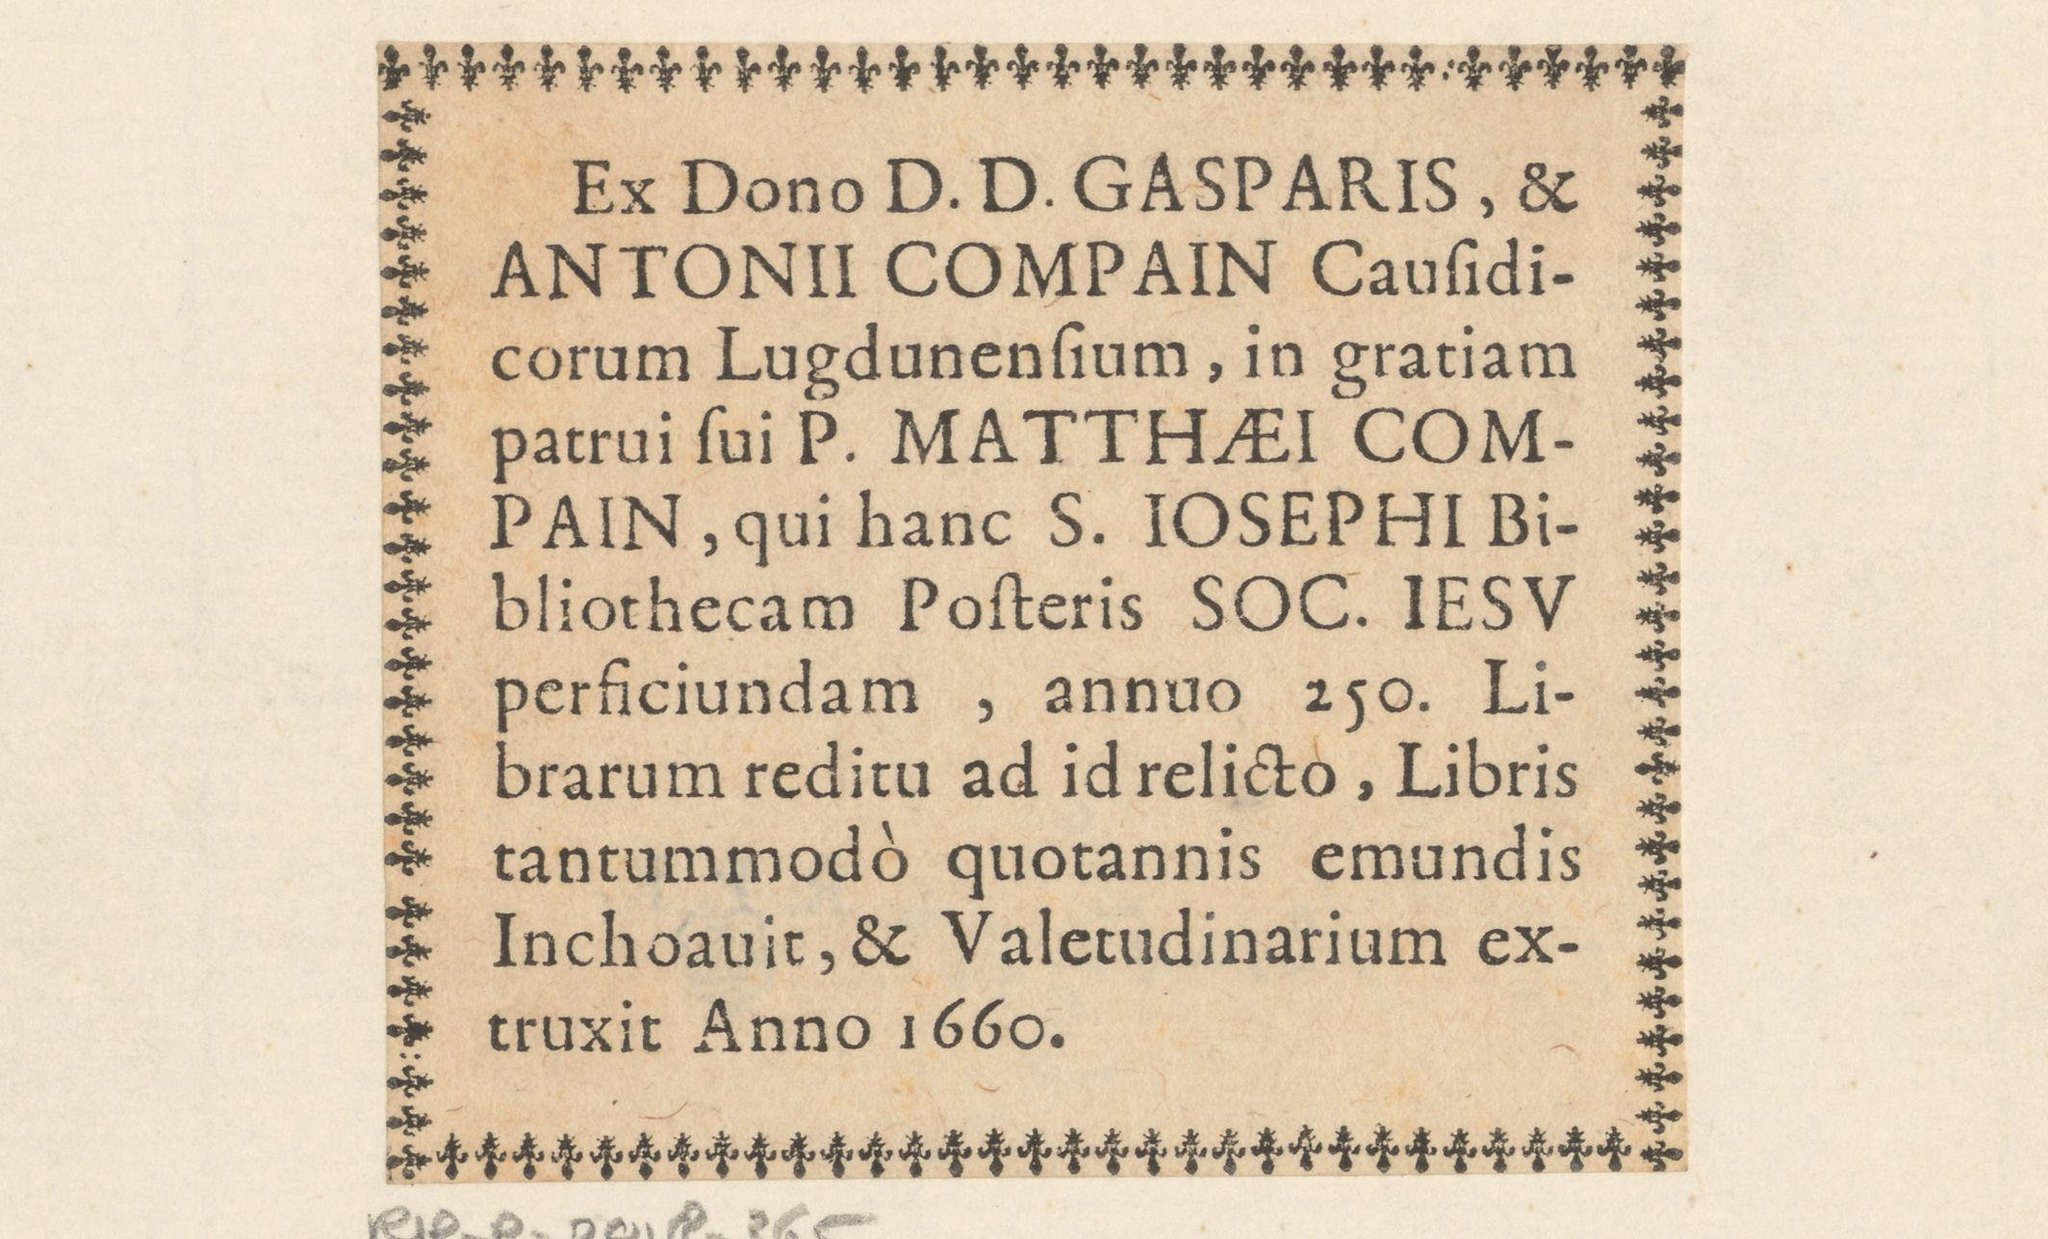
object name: bookplate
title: Ex dono d.d. Gasparis, & Antonii Compain (...)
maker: Anonymous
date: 1660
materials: paper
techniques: letterpress printing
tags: leiden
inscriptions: collector's mark: Lugt 2760, collector's mark: Lugt 2233